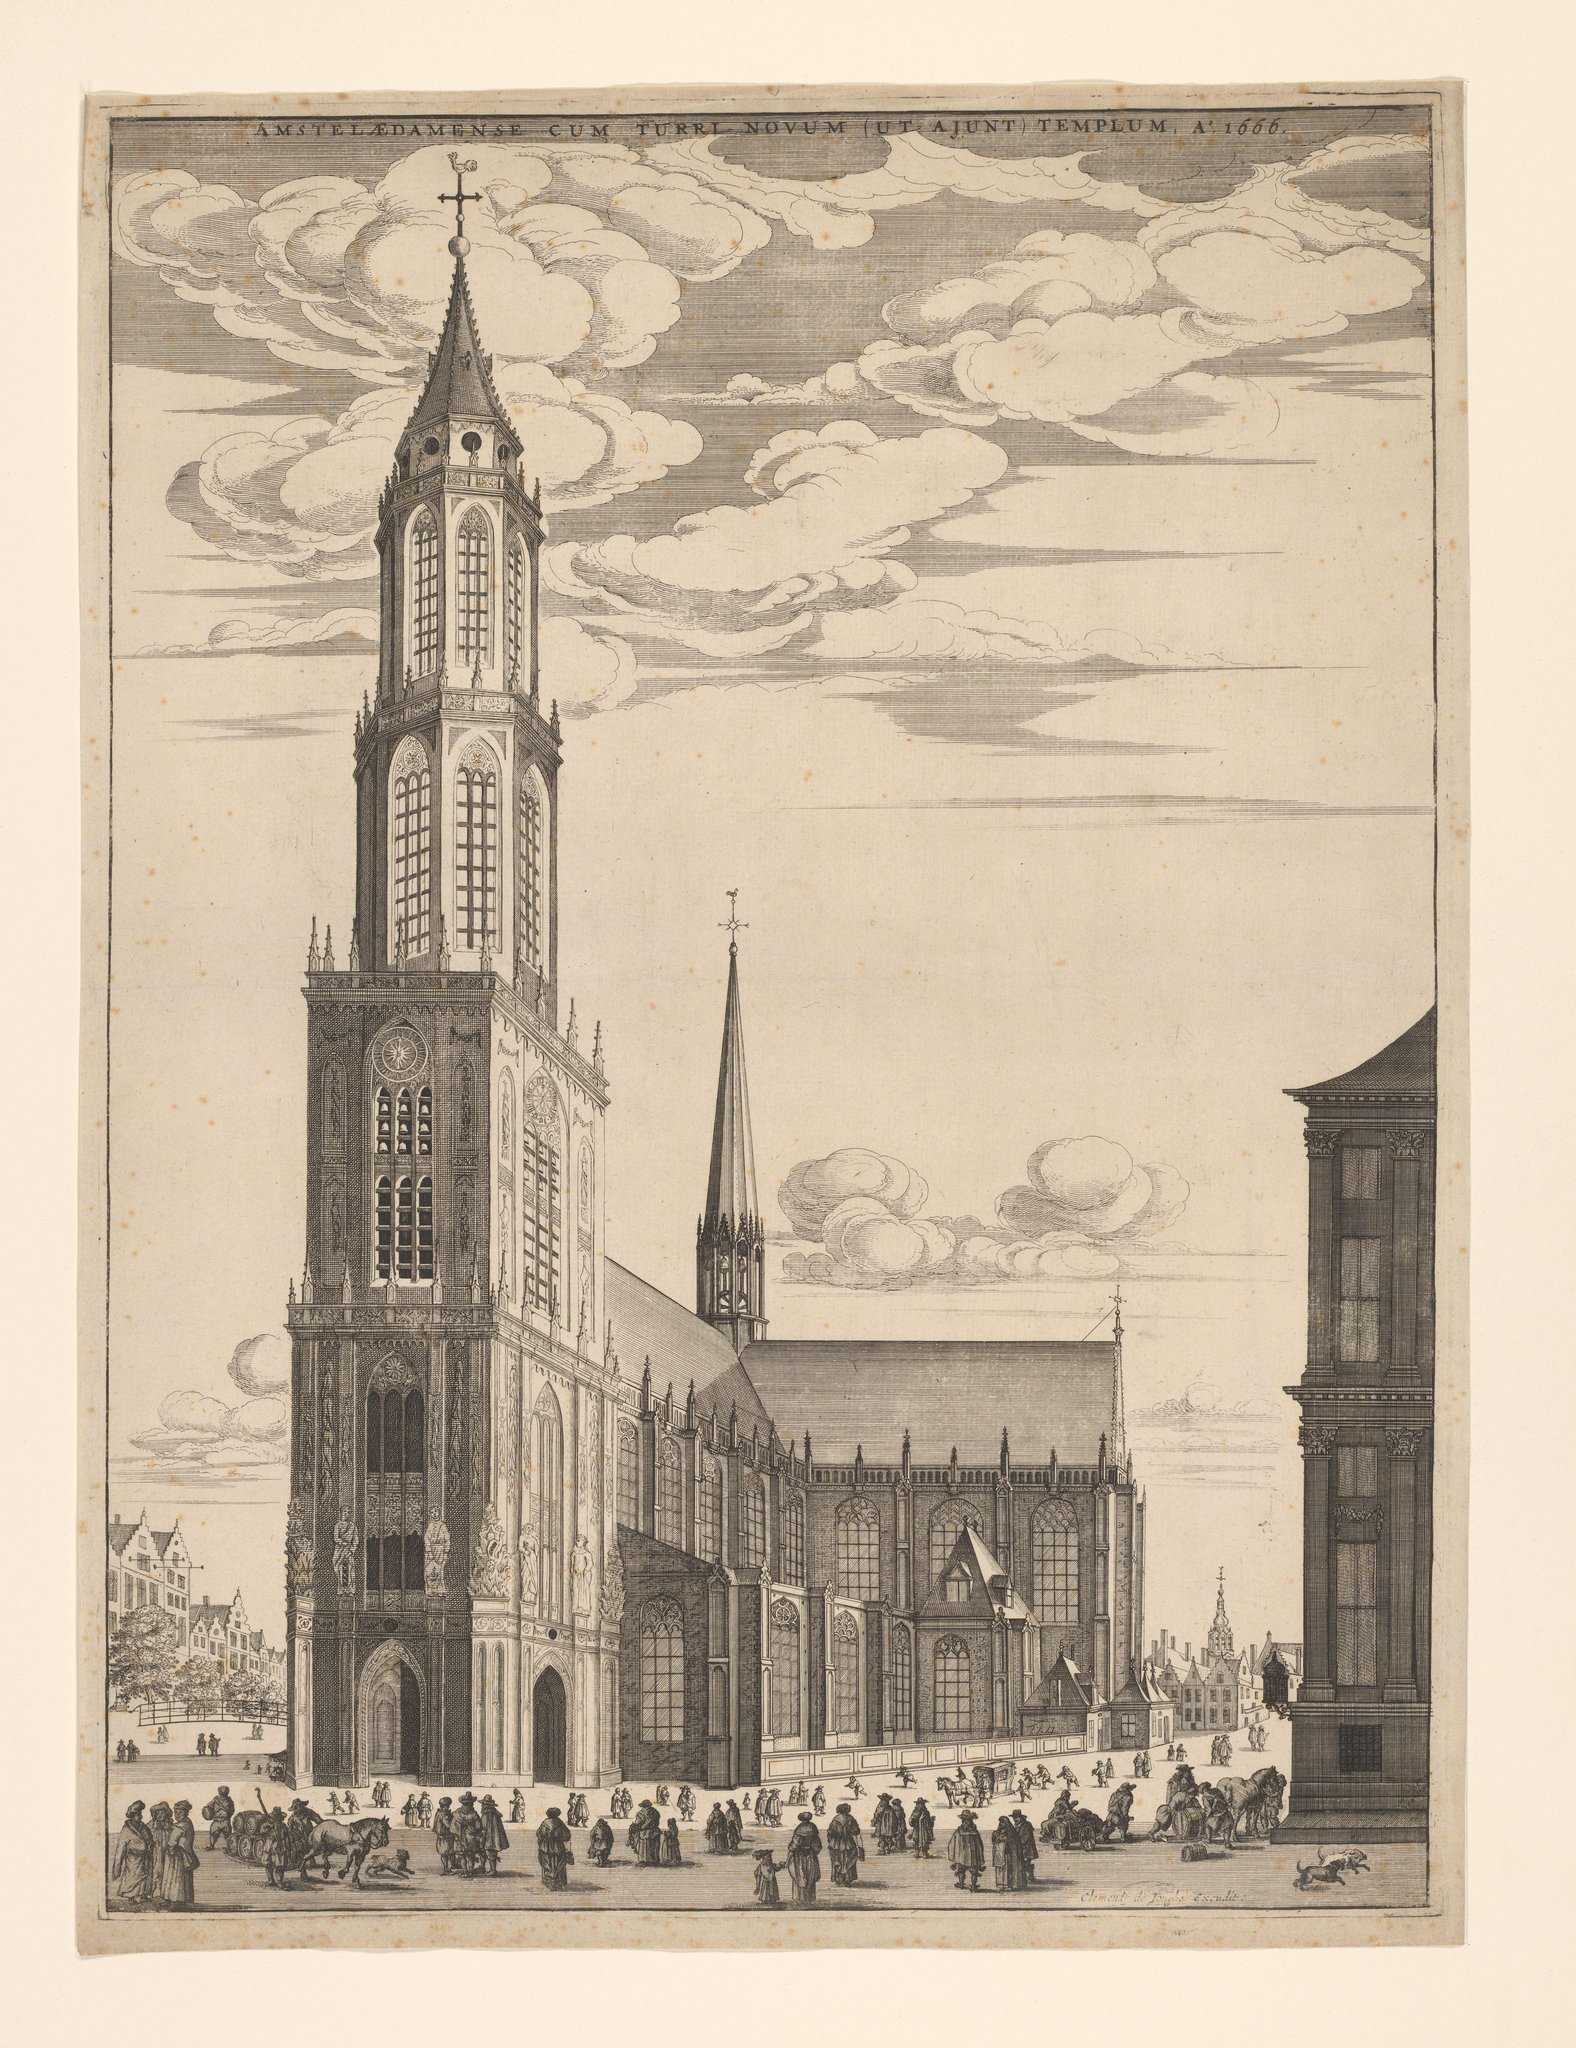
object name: print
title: Ontwerp voor de toren van de Nieuwe Kerk te Amsterdam.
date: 1666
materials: paper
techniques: engraving, etching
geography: netherlands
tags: crafts and industries (+ transport of products ~ crafts, industries, agriculture), animal-drawn sledge (dutch: 'toeslede'), amsterdam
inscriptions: collector's mark: Lugt 2228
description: Gezicht op de Nieuwe Kerk, met de geprojecteerde toren. Links de toren, rechts een gedeelte van 't stadhuis. Op de voorgrond links drie bierdragers met een met biertonnen beladen slede, waarvoor een paard. Rechts twee spelende honden.